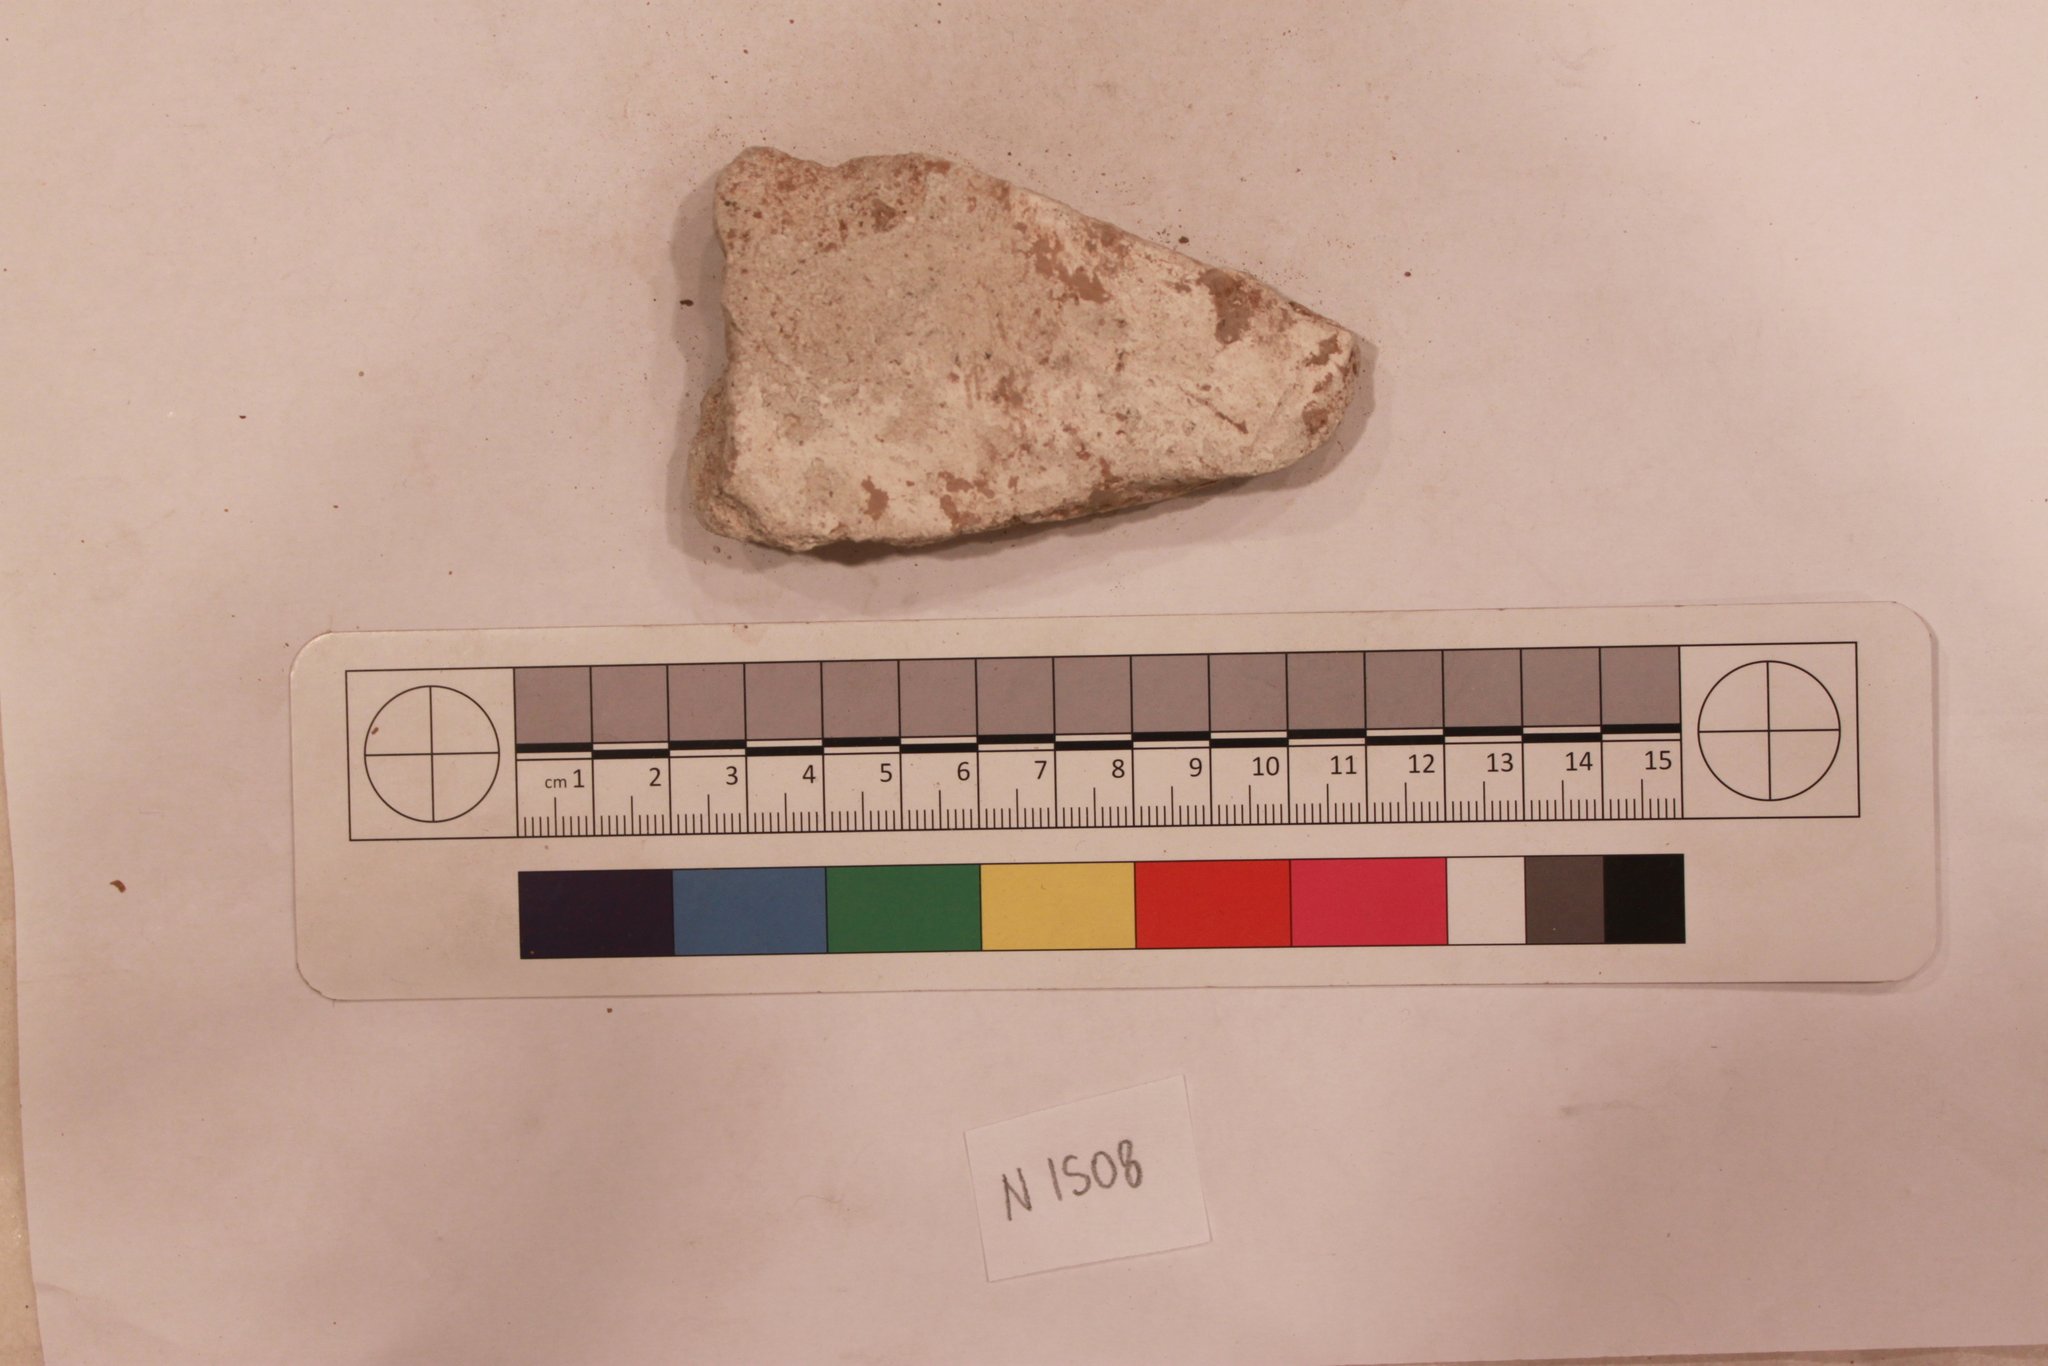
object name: fragment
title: Stucco Fragment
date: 701-1200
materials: plaster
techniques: carving, painting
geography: iran